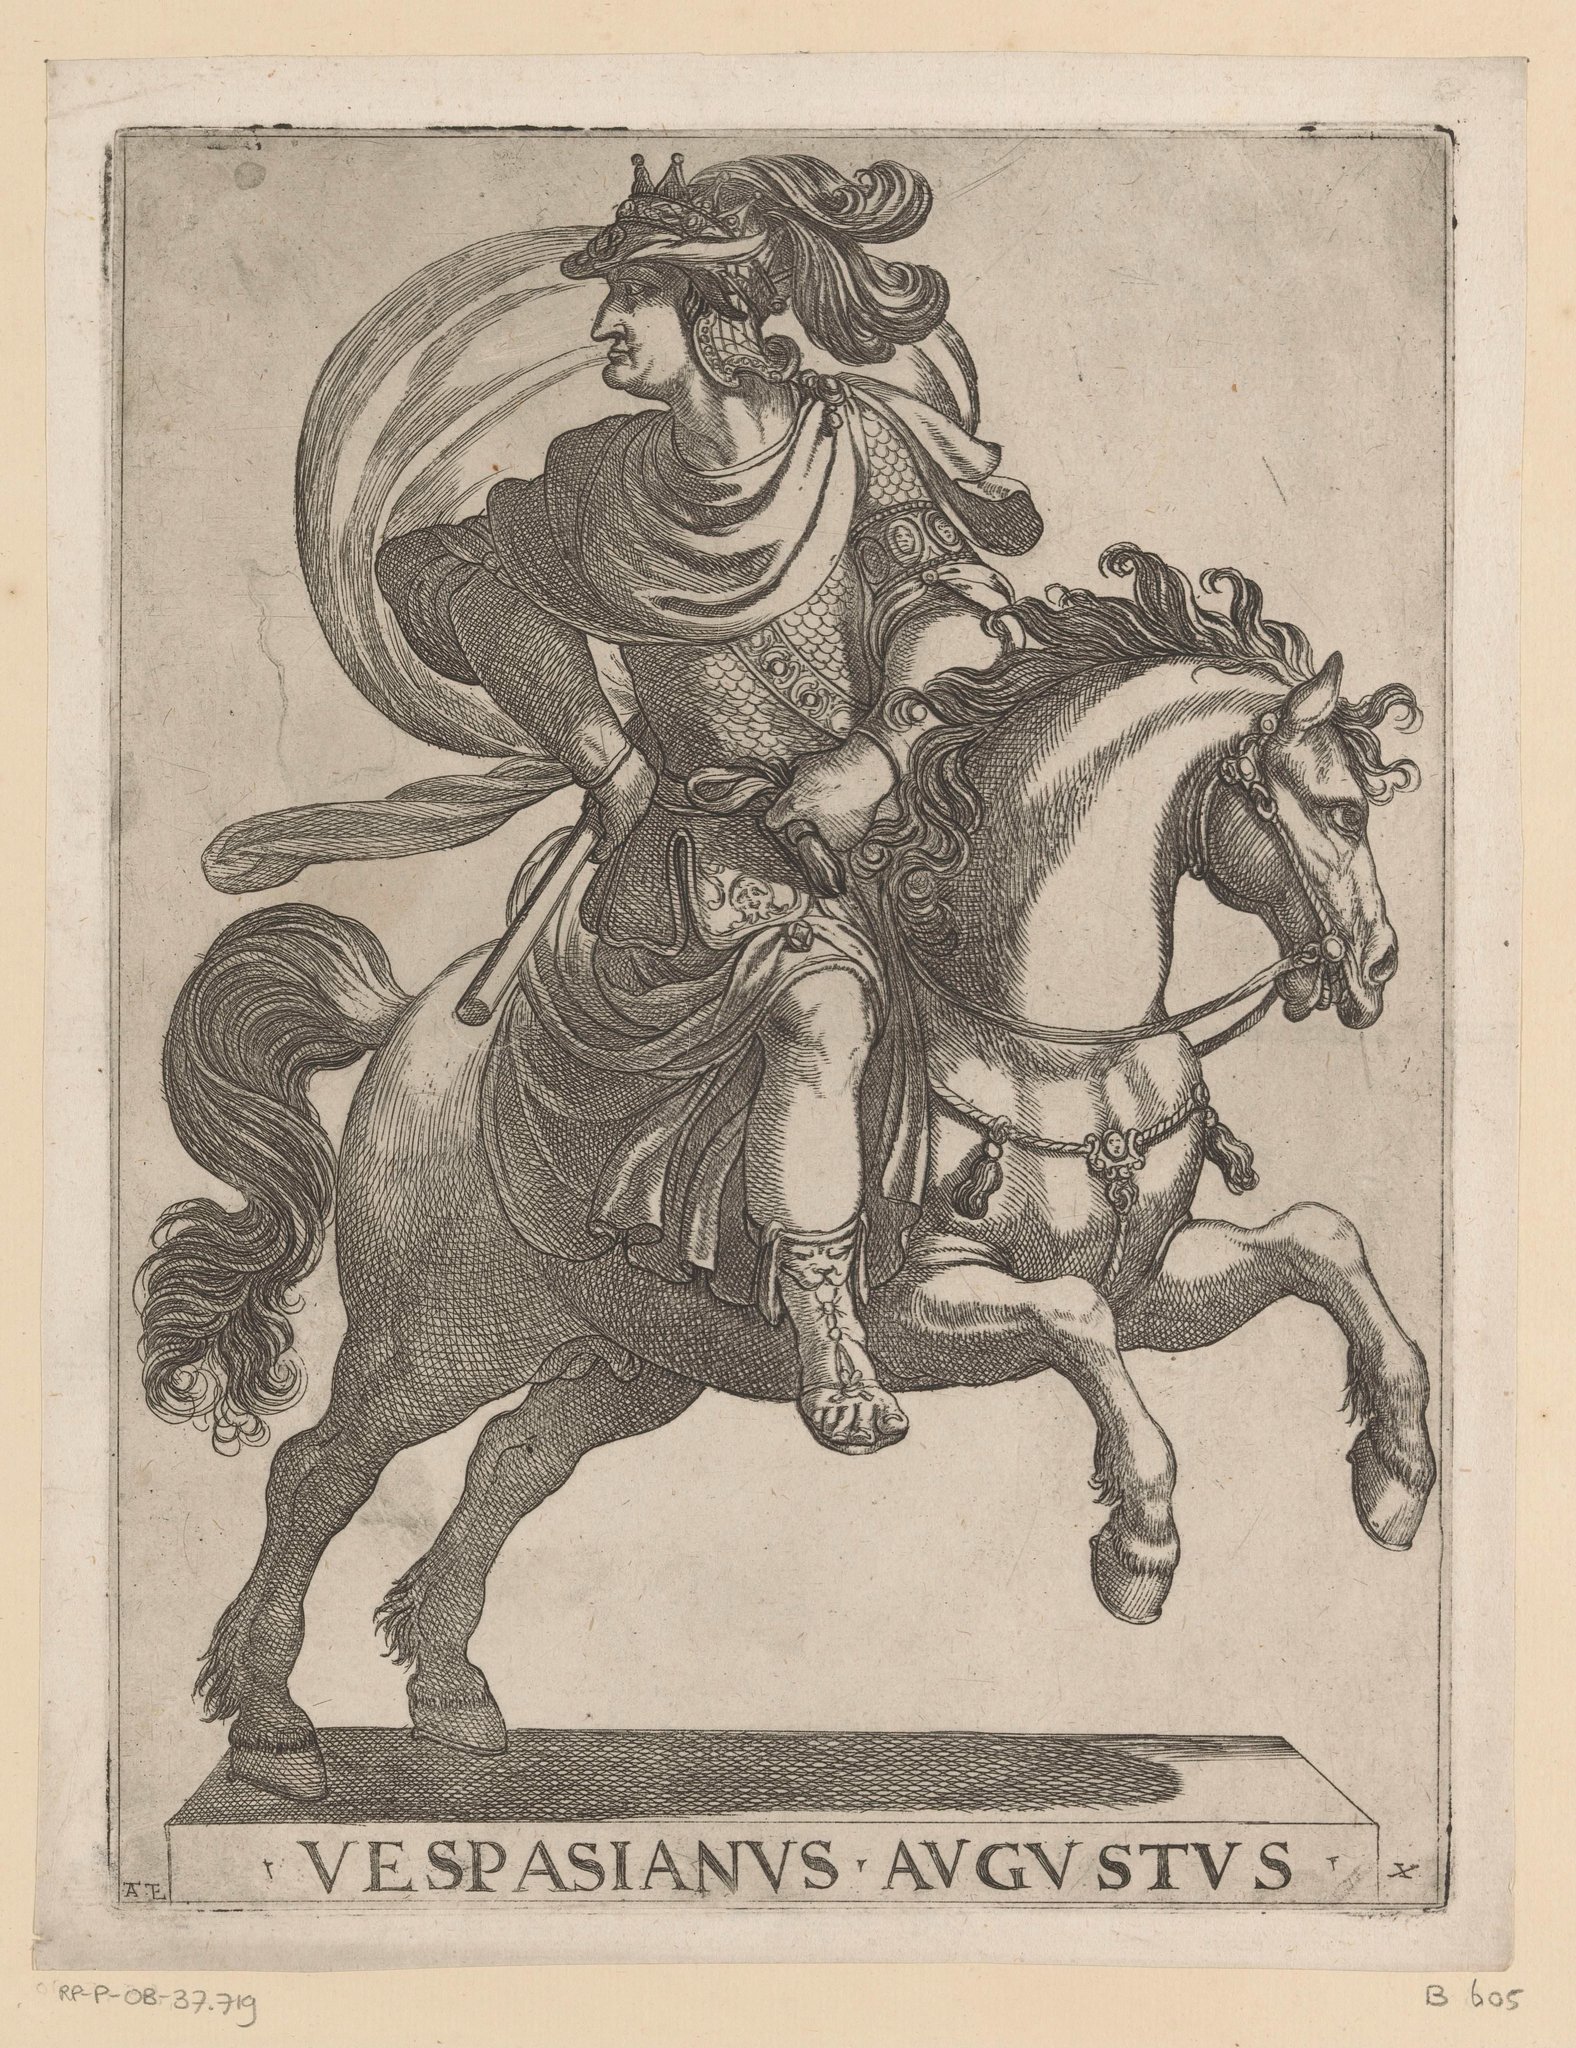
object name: print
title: XII caesares in equestri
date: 1596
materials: paper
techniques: etching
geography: italy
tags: portrait of vespasian, equestrian statue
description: Titelprent bij een reeks van twaalf prenten van Romeinse keizers.